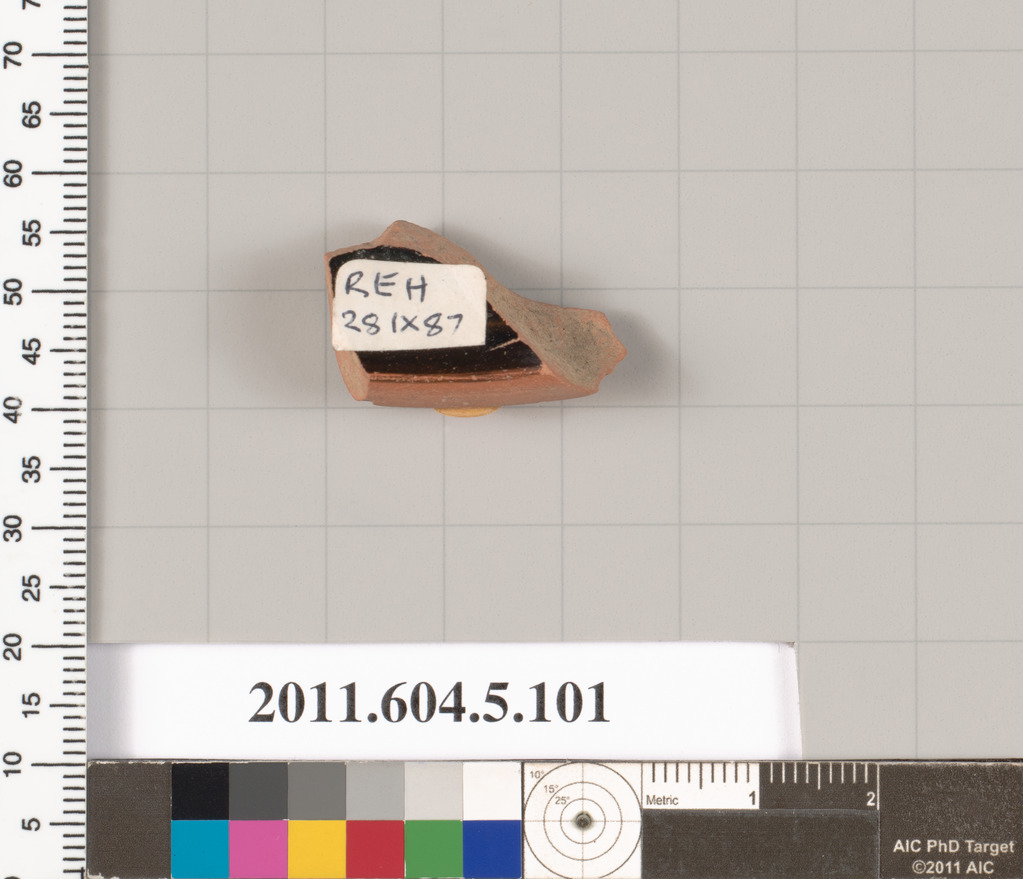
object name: kylix fragment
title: Terracotta fragment of a stemless kylix (drinking cup)?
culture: greek, attic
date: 470-450 BCE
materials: terracotta